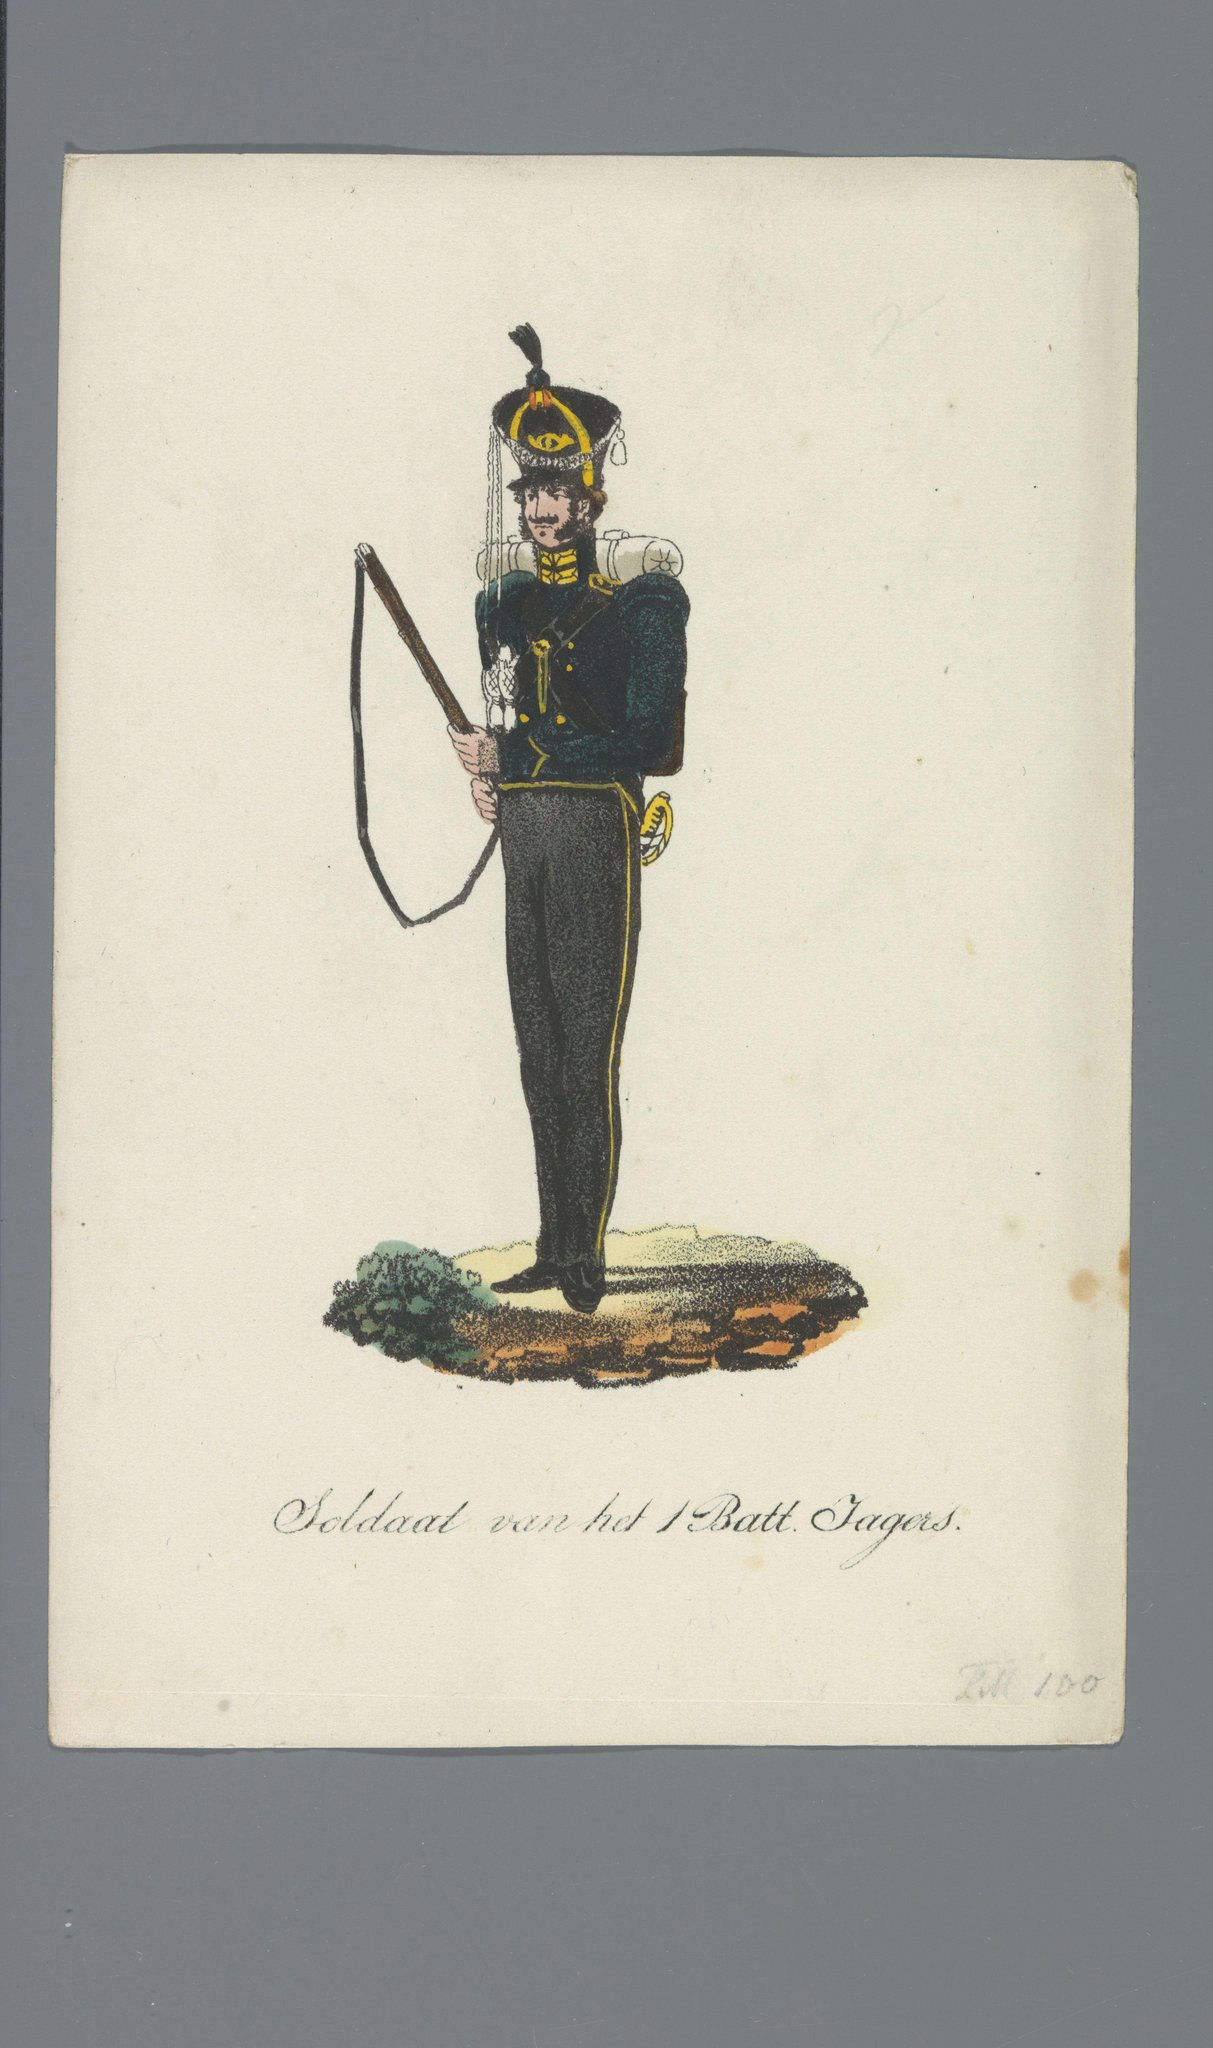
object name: costume print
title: Soldaat van het 1 Batt. Jagers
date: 1835-1850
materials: paper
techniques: hand coloring, lithograph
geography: utrecht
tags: (military) uniforms, clothes, costume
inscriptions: collector's mark: Lugt 2228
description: Een soldaat van het 1e Bataljon Jagers, te voet. Onderdeel van een serie van 157 losse bladen met Nederlandse militaire uniformen in de jaren 1830-1832.